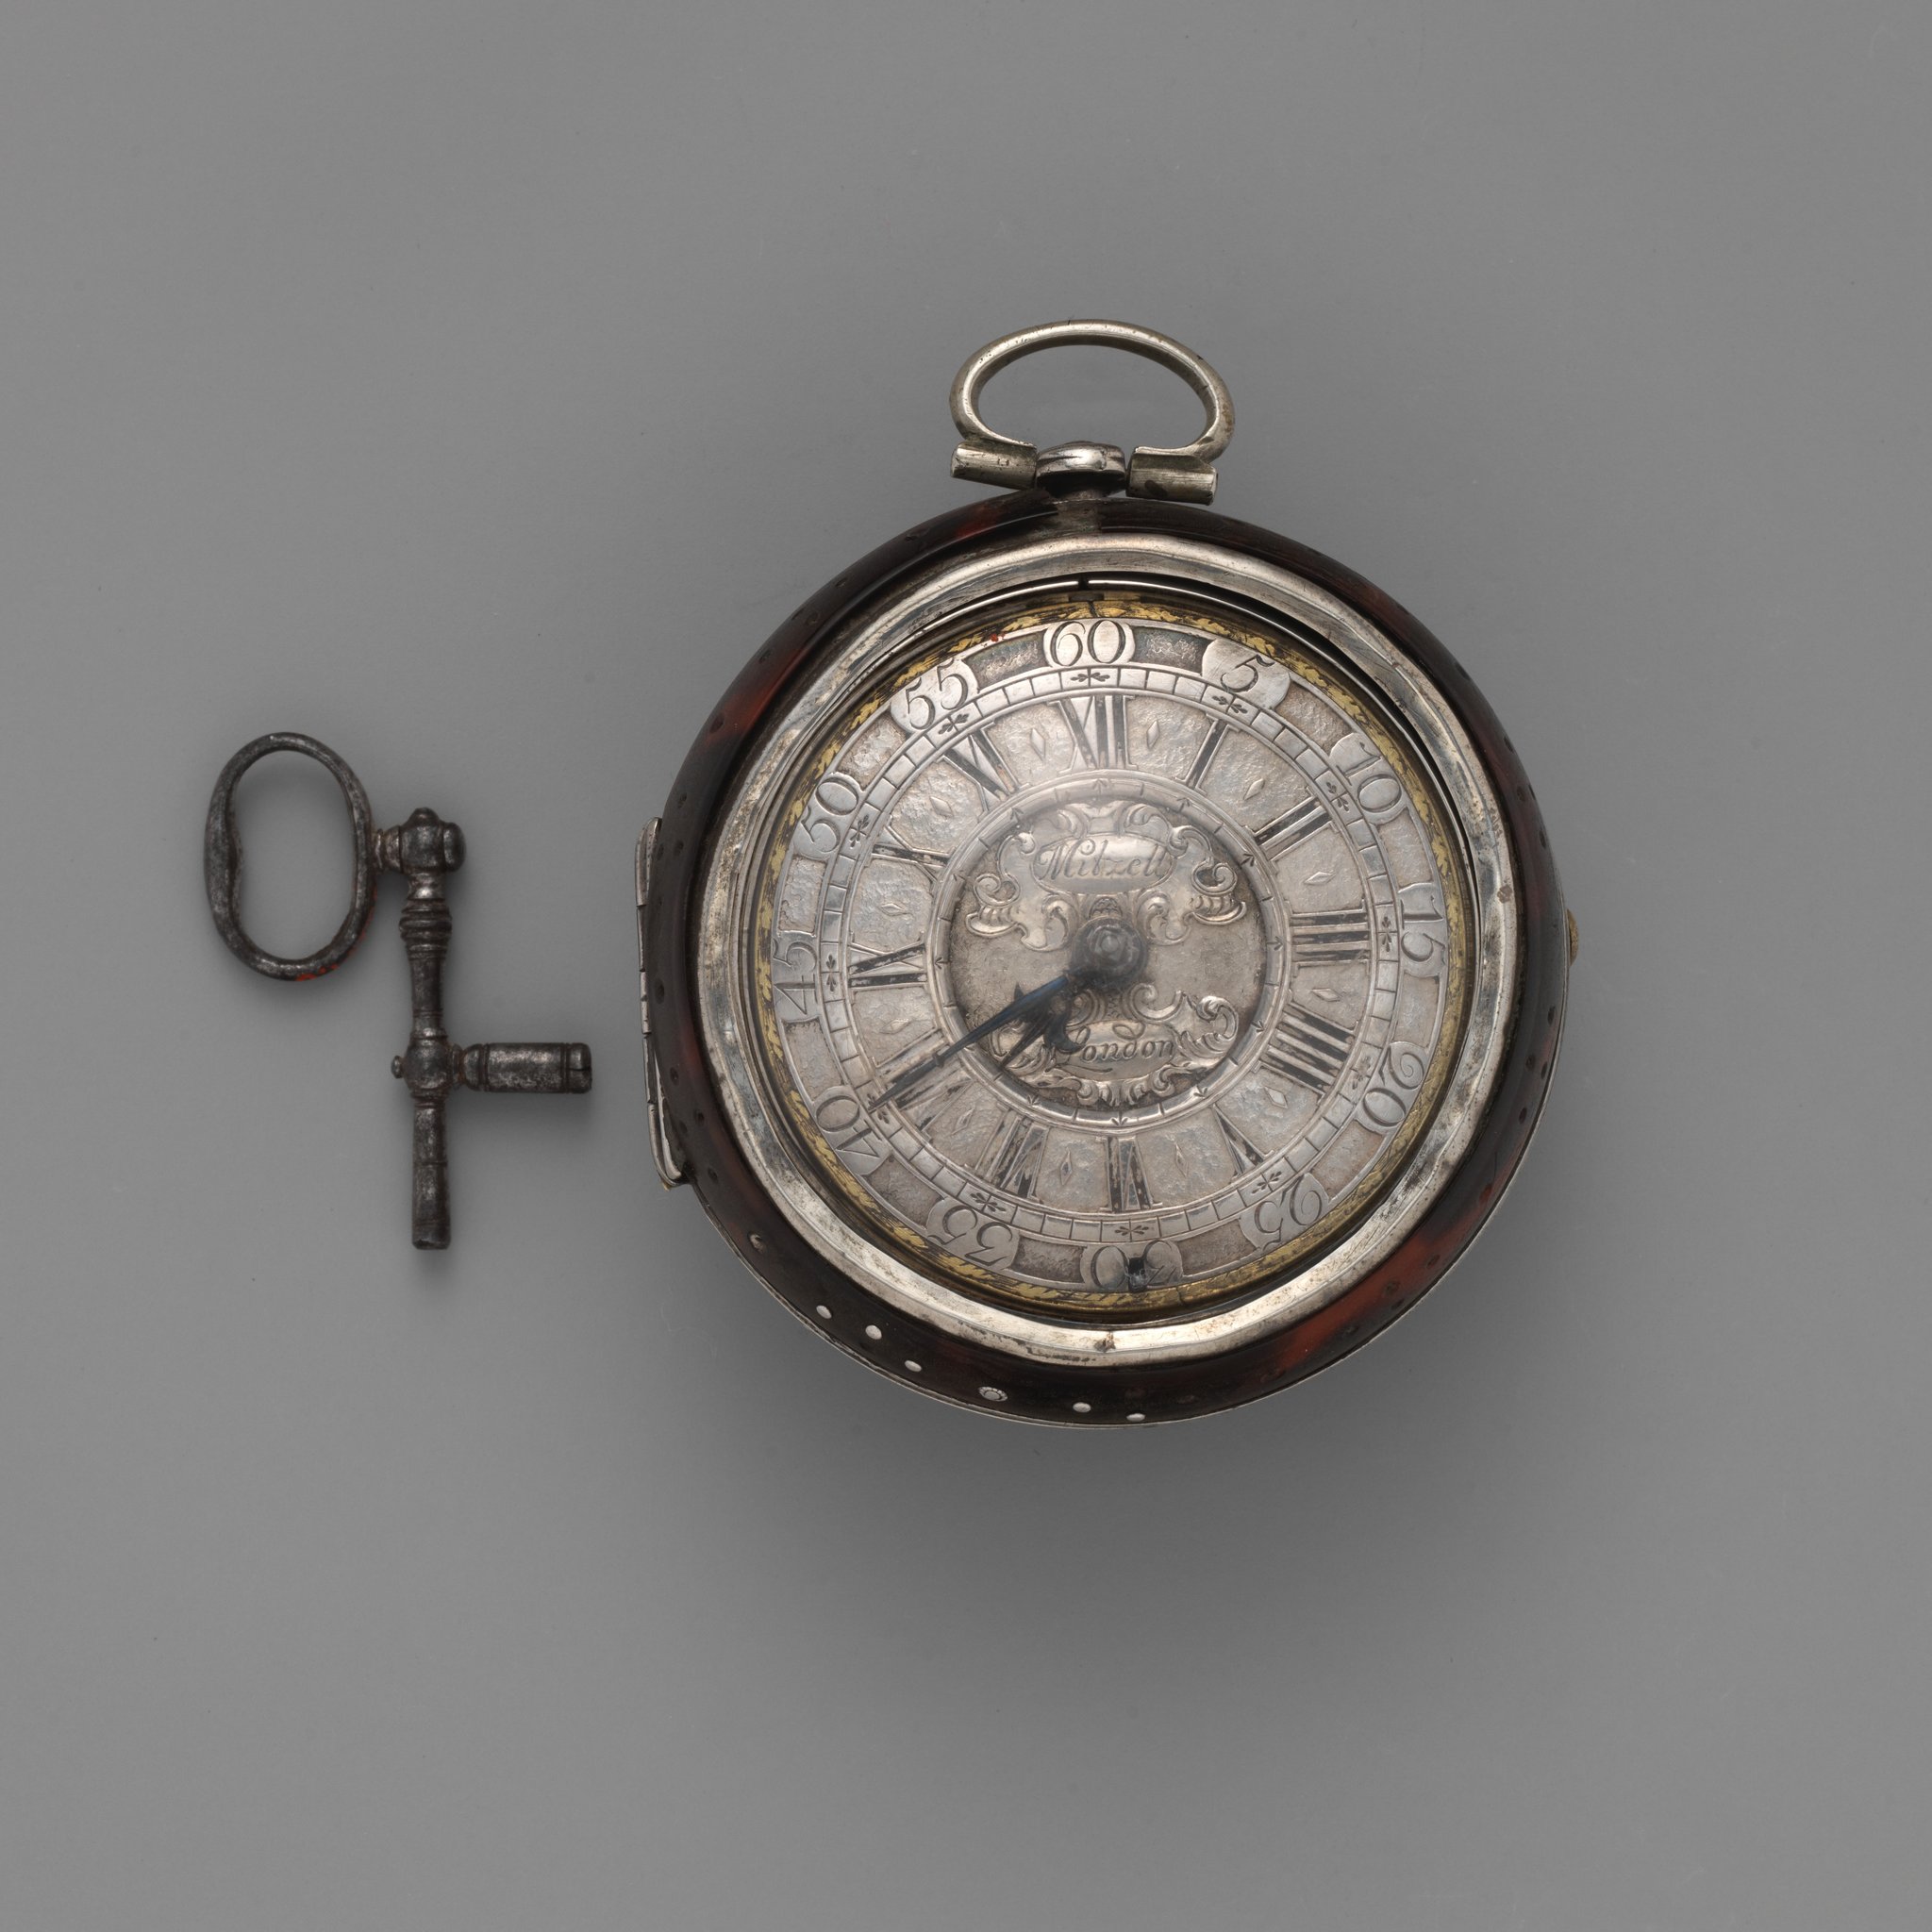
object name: watch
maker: john mitzell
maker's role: maker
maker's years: 1650-1750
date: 1697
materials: silver, shell